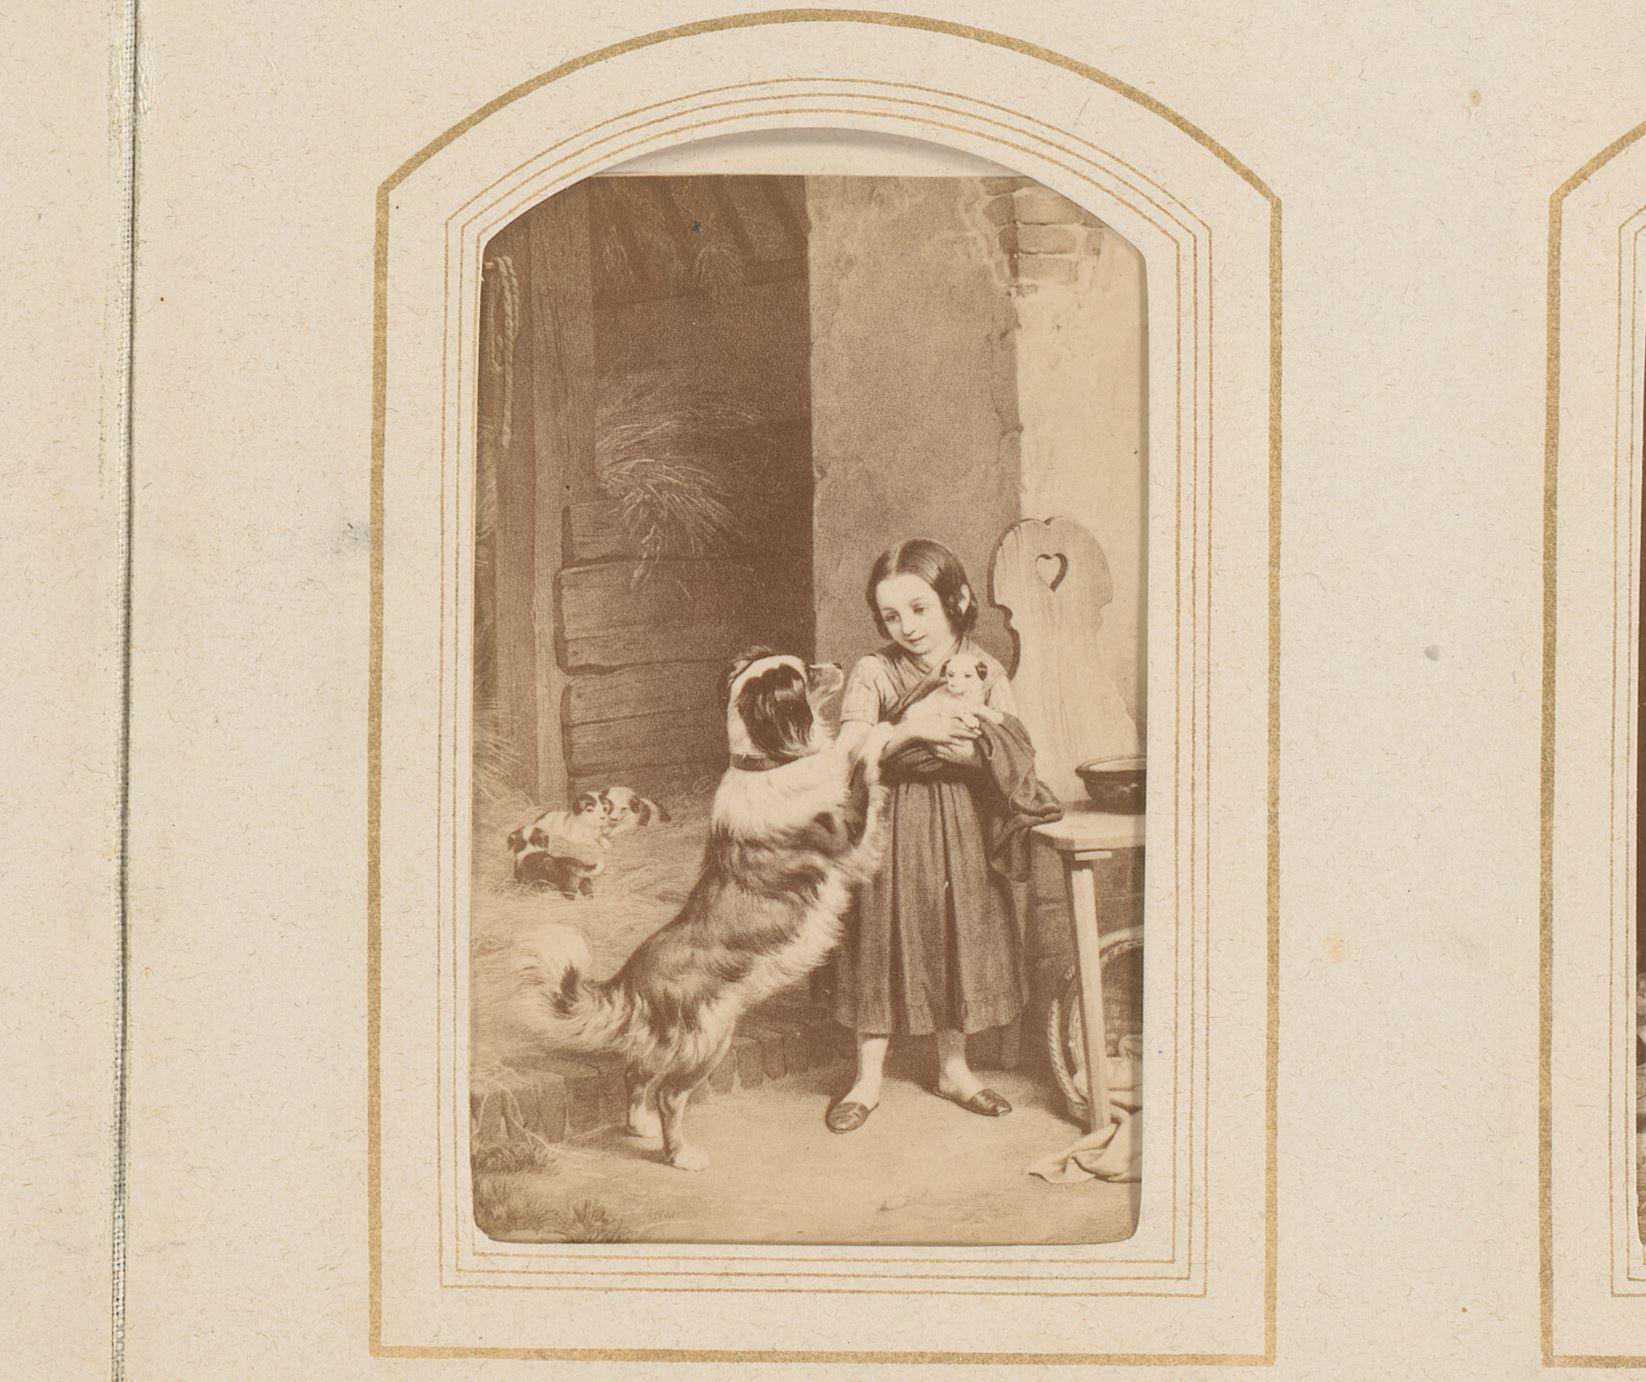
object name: photograph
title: Fotoreproductie van Mütterliche Besorgnis door Friedrich Eduard Meyerheim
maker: Anonymous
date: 1870-1890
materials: cardboard, photographic support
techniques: albumen print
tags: girl (child between toddler and youth), dog, painting, drawing and the graphic arts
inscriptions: annotation: ‘Mütterliche Besorgnis’, inscription: ‘1357 Collection moderne’